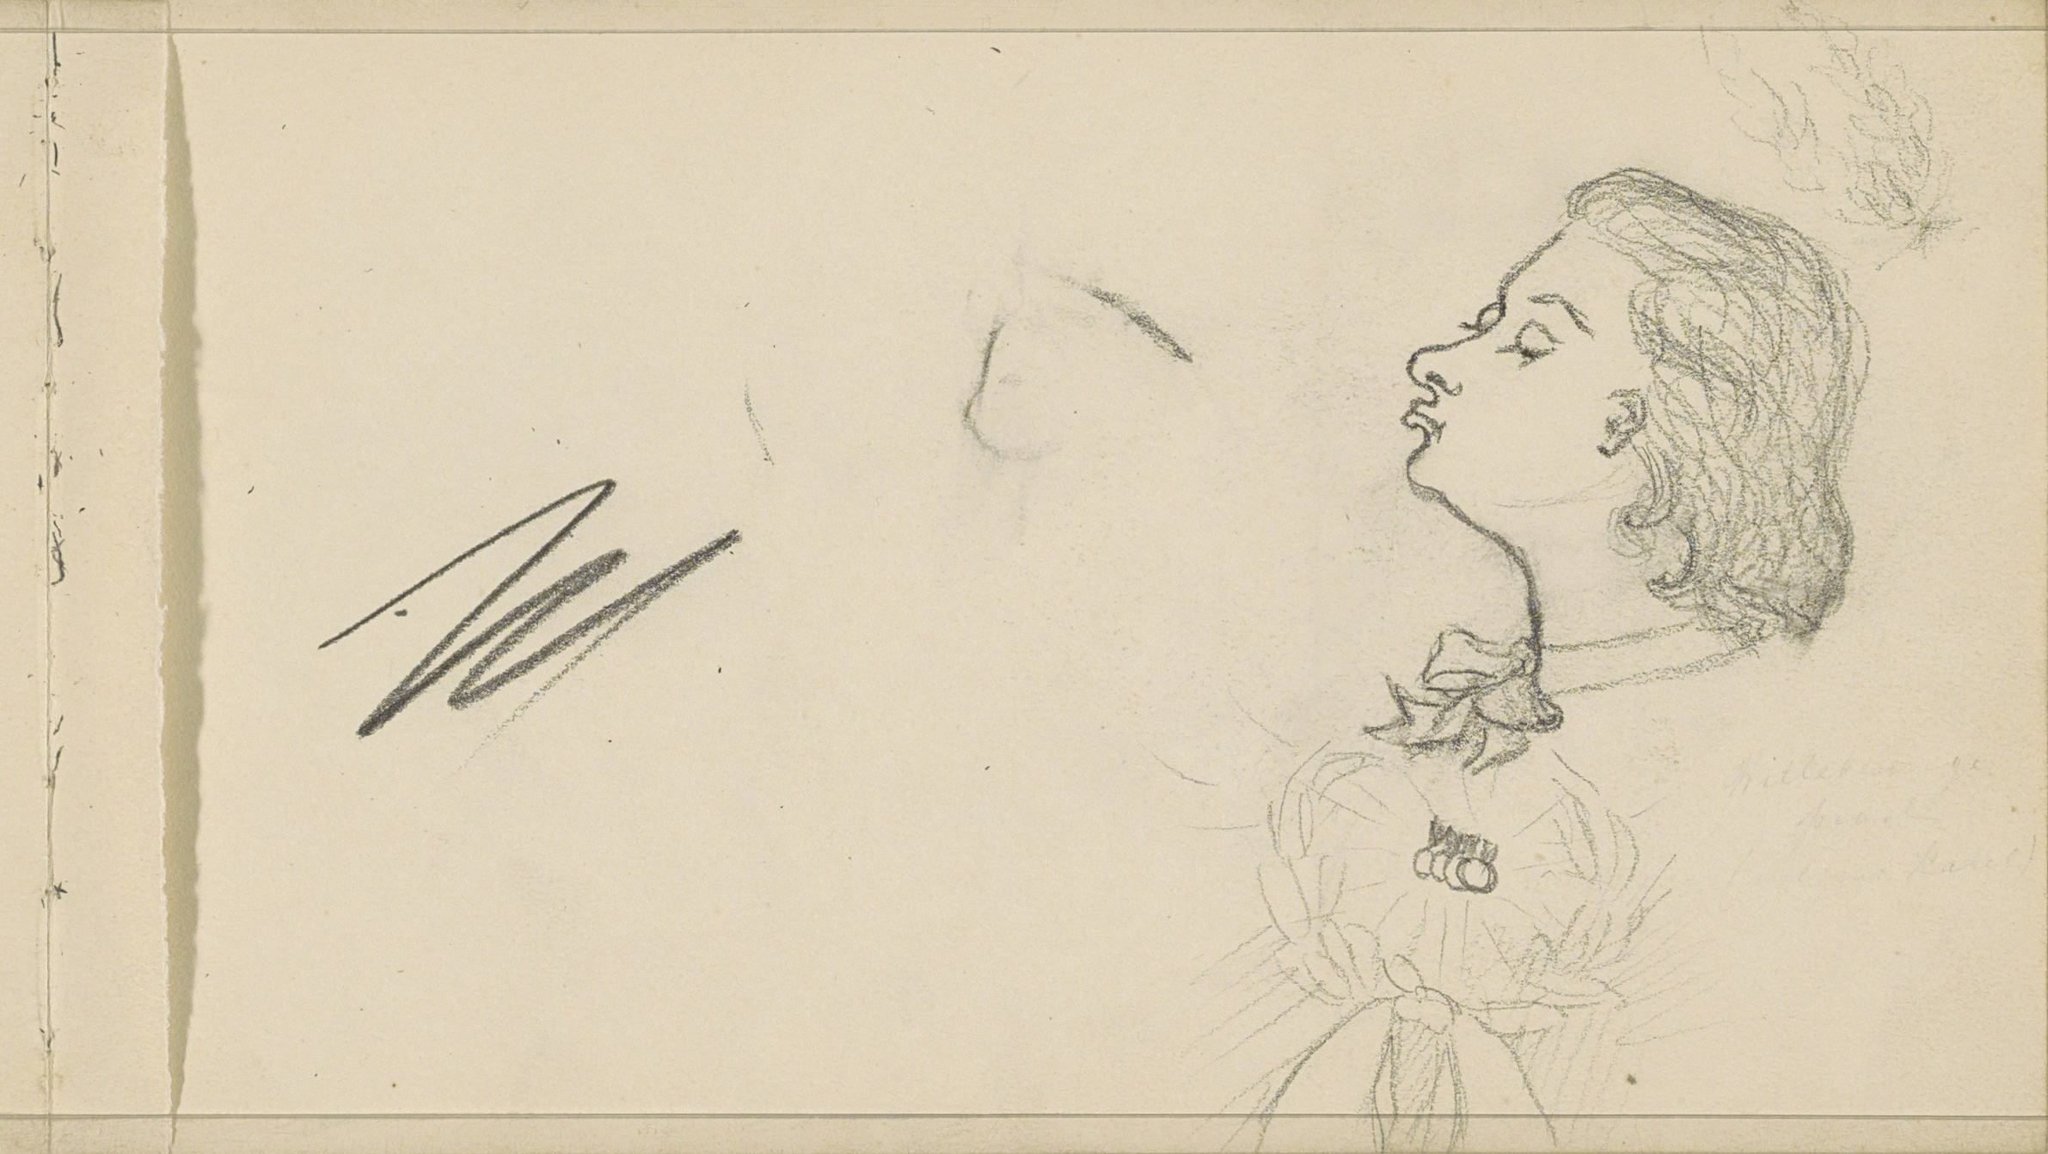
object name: sketchbook leaf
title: Kop van een vrouw met getuite lippen en half gesloten ogen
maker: julie de graag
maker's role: draughtsman, print maker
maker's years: 1877-1924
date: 1892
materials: paper, pencil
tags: adult woman, lips pressed together, eyes closed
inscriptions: annotation: ‘[...]ite[...] ge/ [...] Karel’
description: Blad 5 recto uit een schetsboek met 22 bladen.